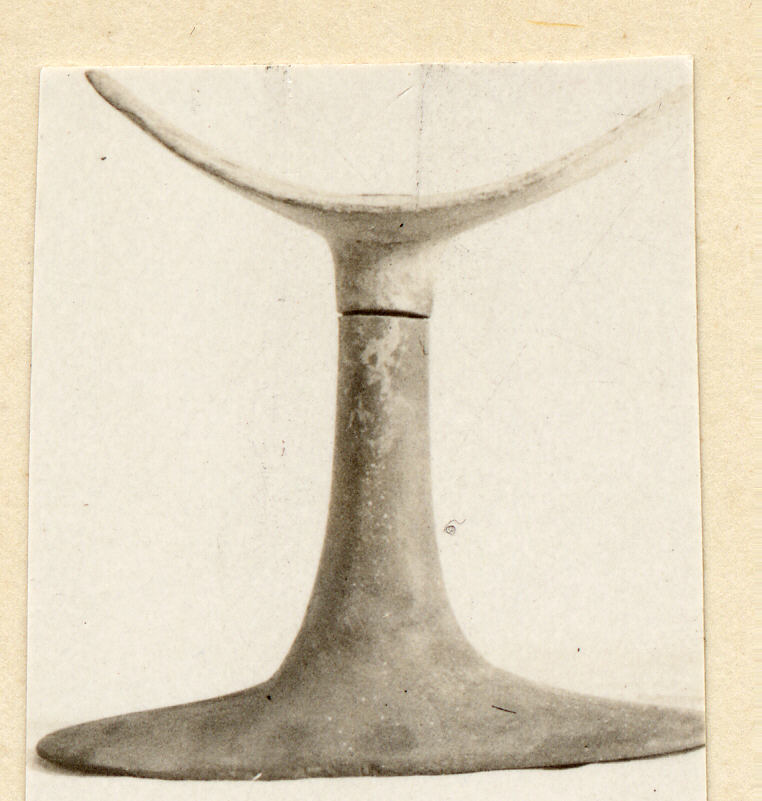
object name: headrest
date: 2030-1640 BCE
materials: wood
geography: egypt